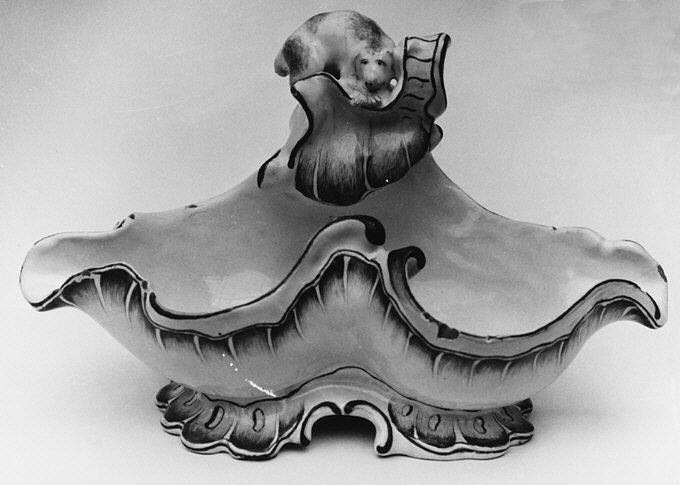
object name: sauceboat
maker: niderviller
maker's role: manufactory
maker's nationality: french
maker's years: 1735-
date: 1760-1770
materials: faience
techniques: glazing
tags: animals